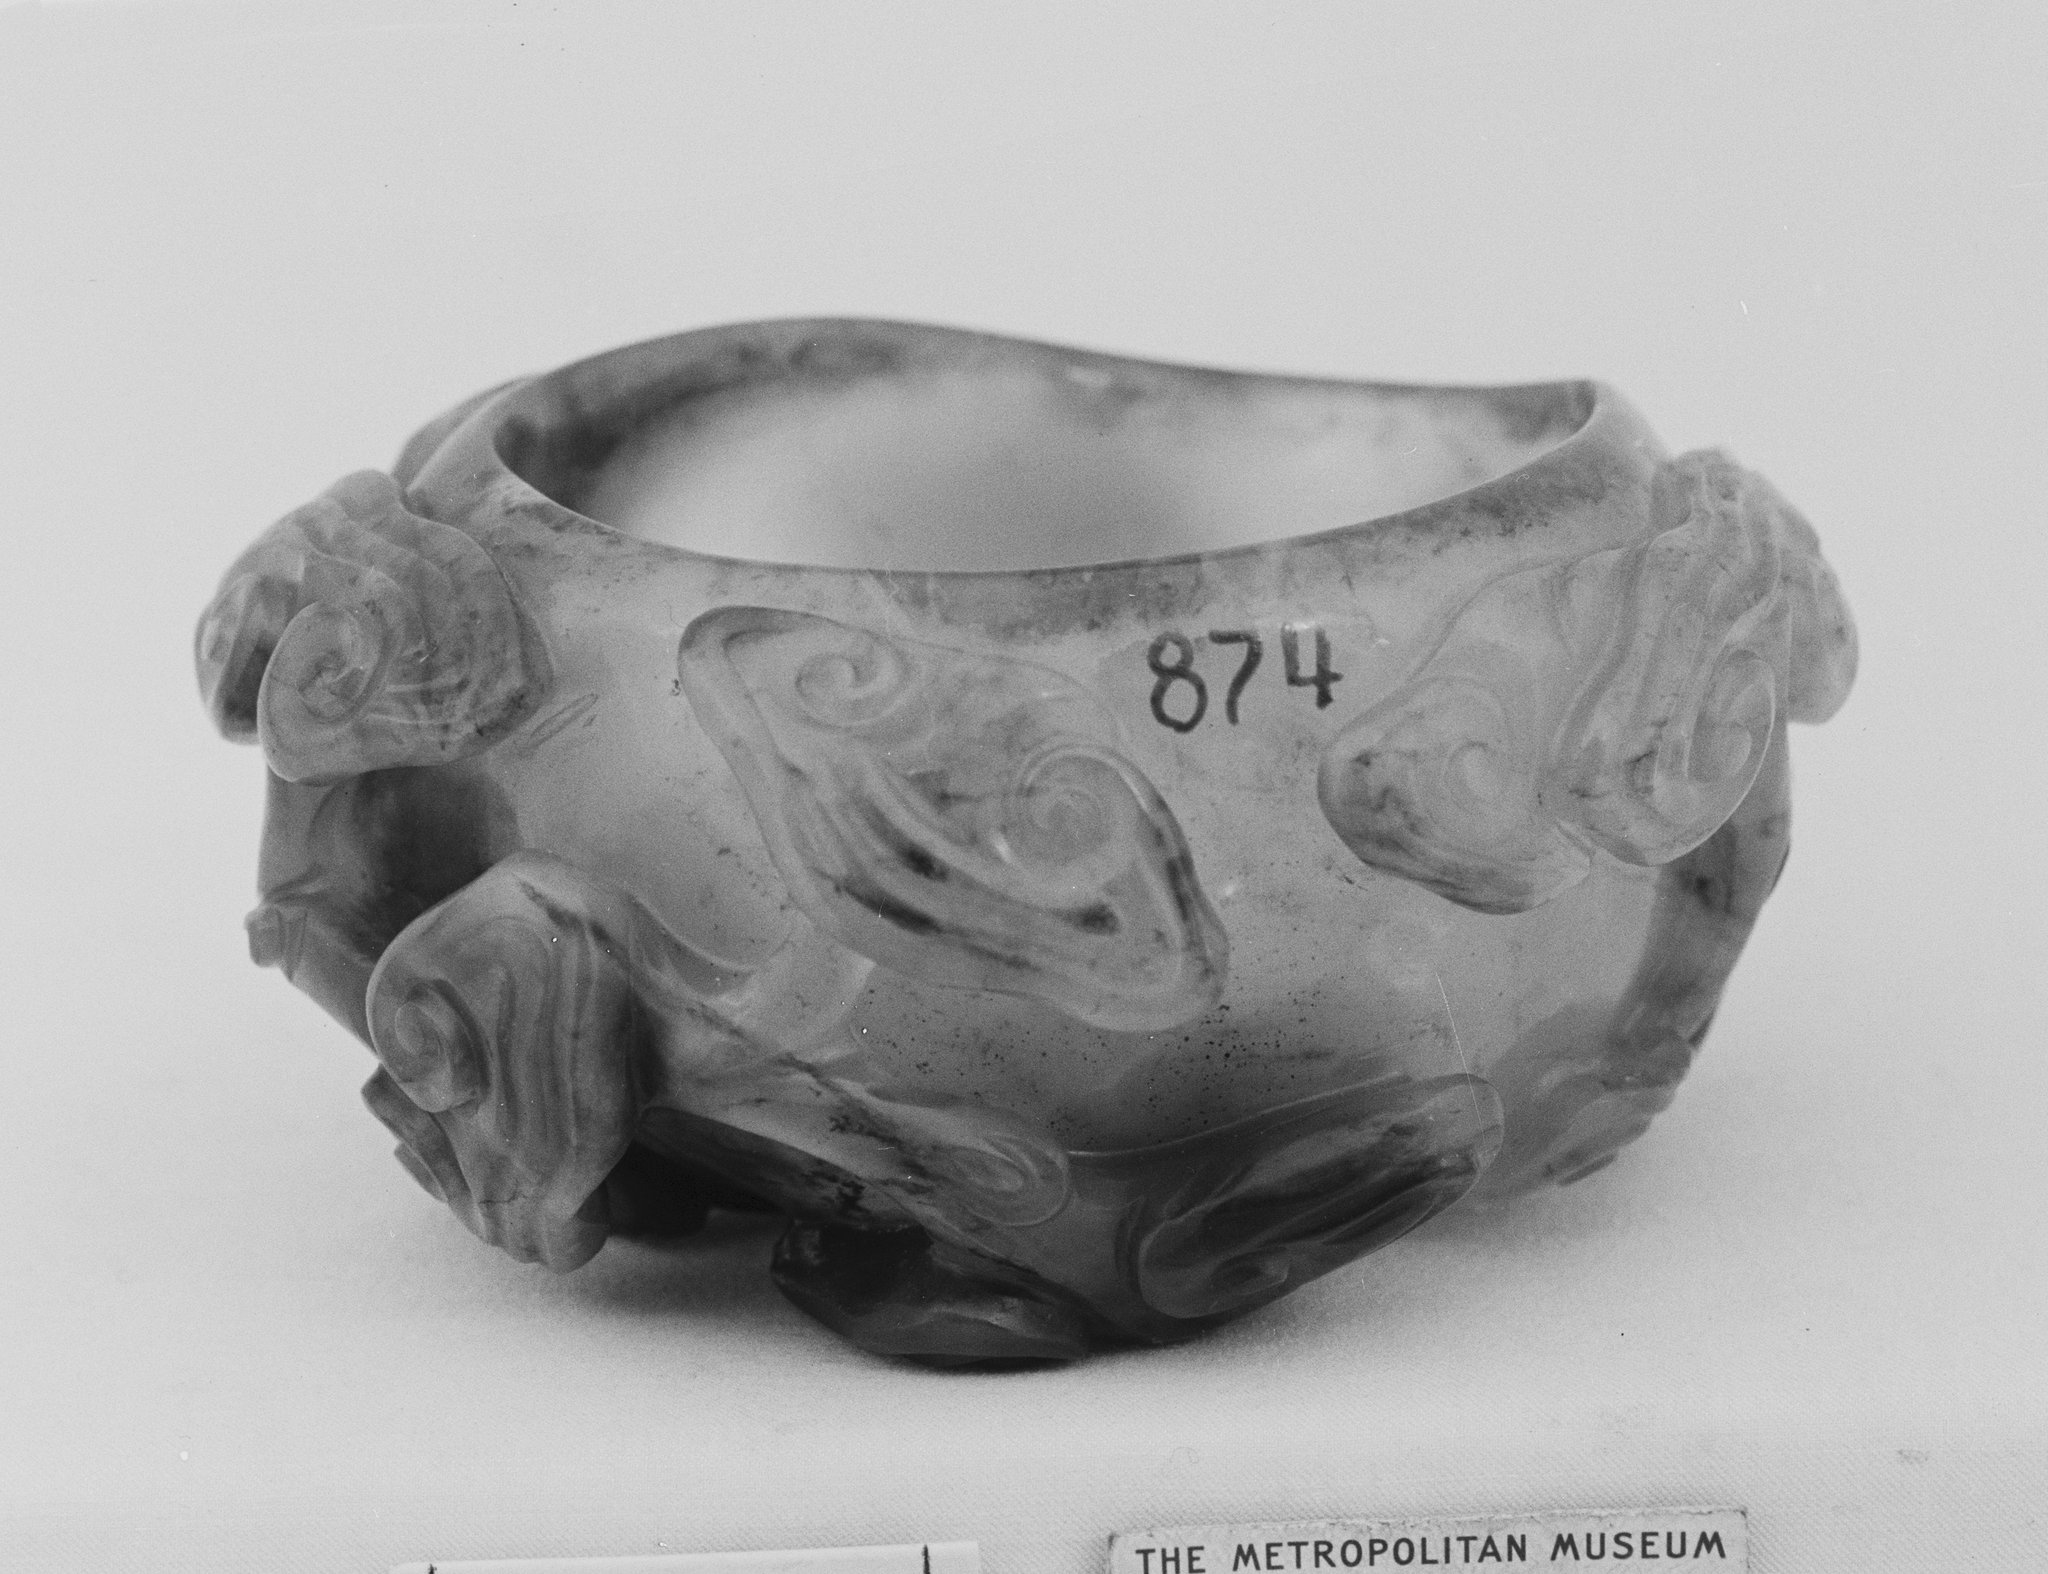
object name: dish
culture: chinese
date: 1701-1800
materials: stone, gemstone